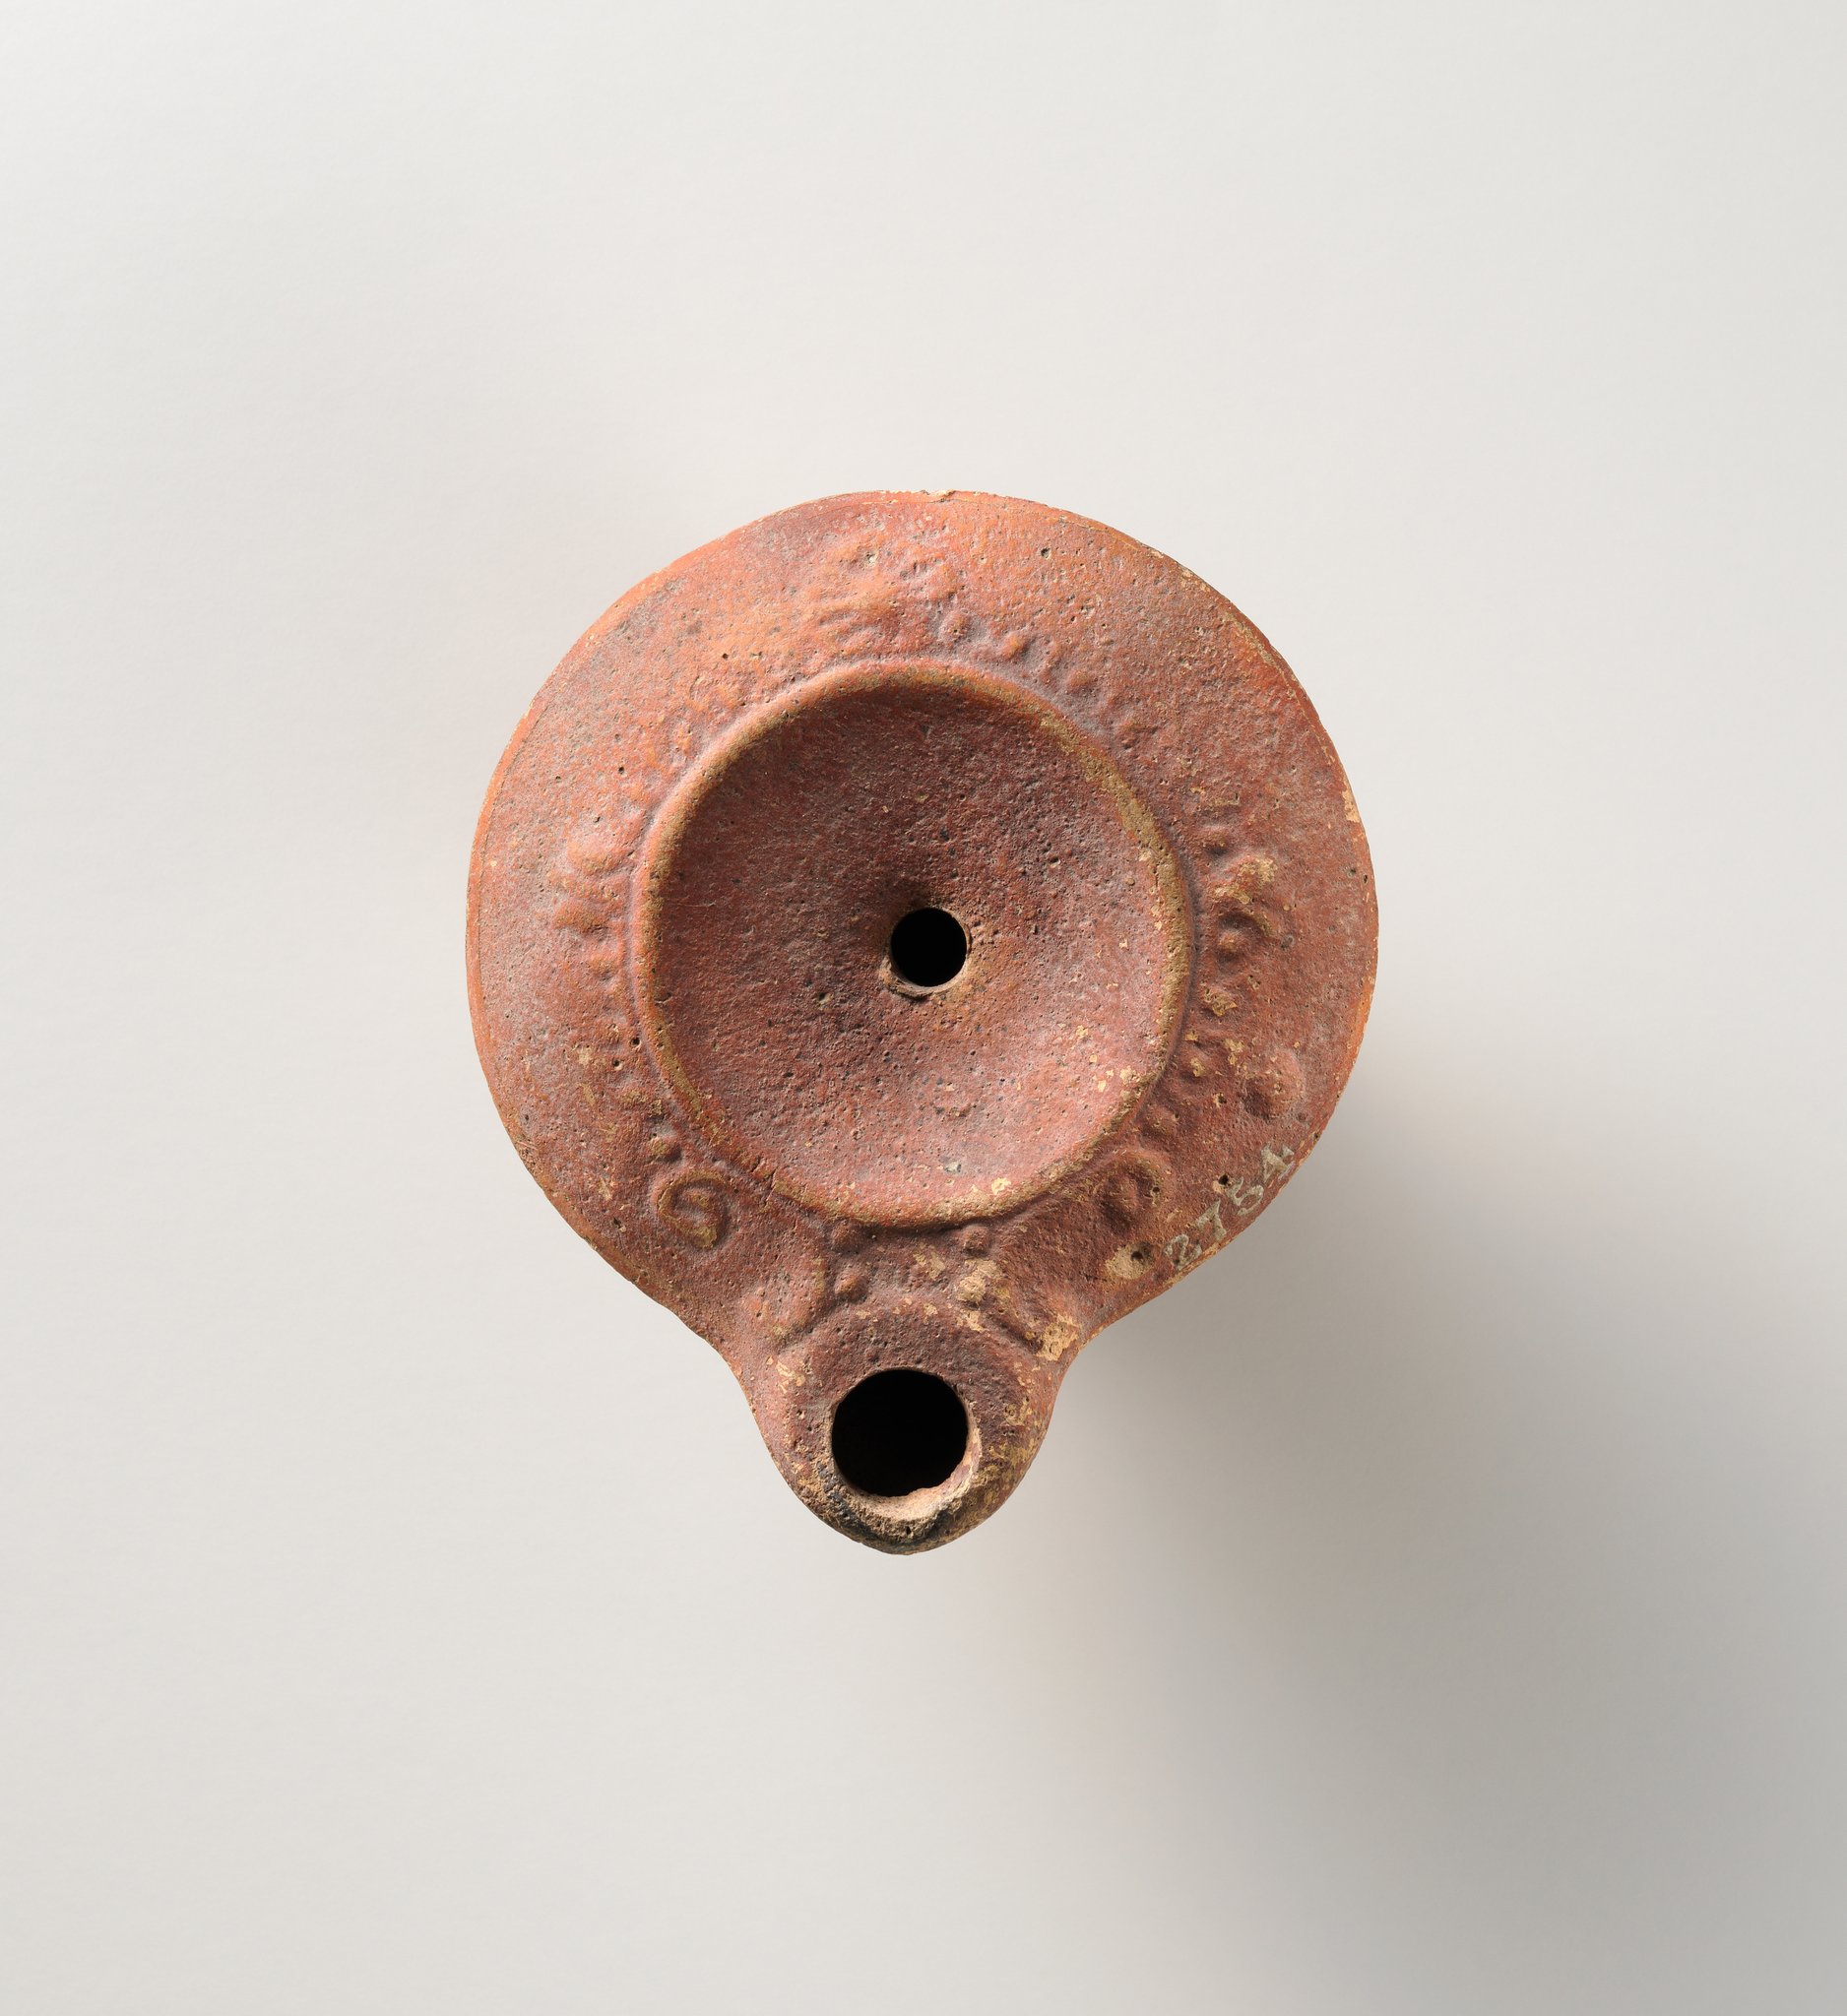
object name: lamp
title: Terracotta oil lamp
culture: roman, cnidian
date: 101-200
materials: terracotta